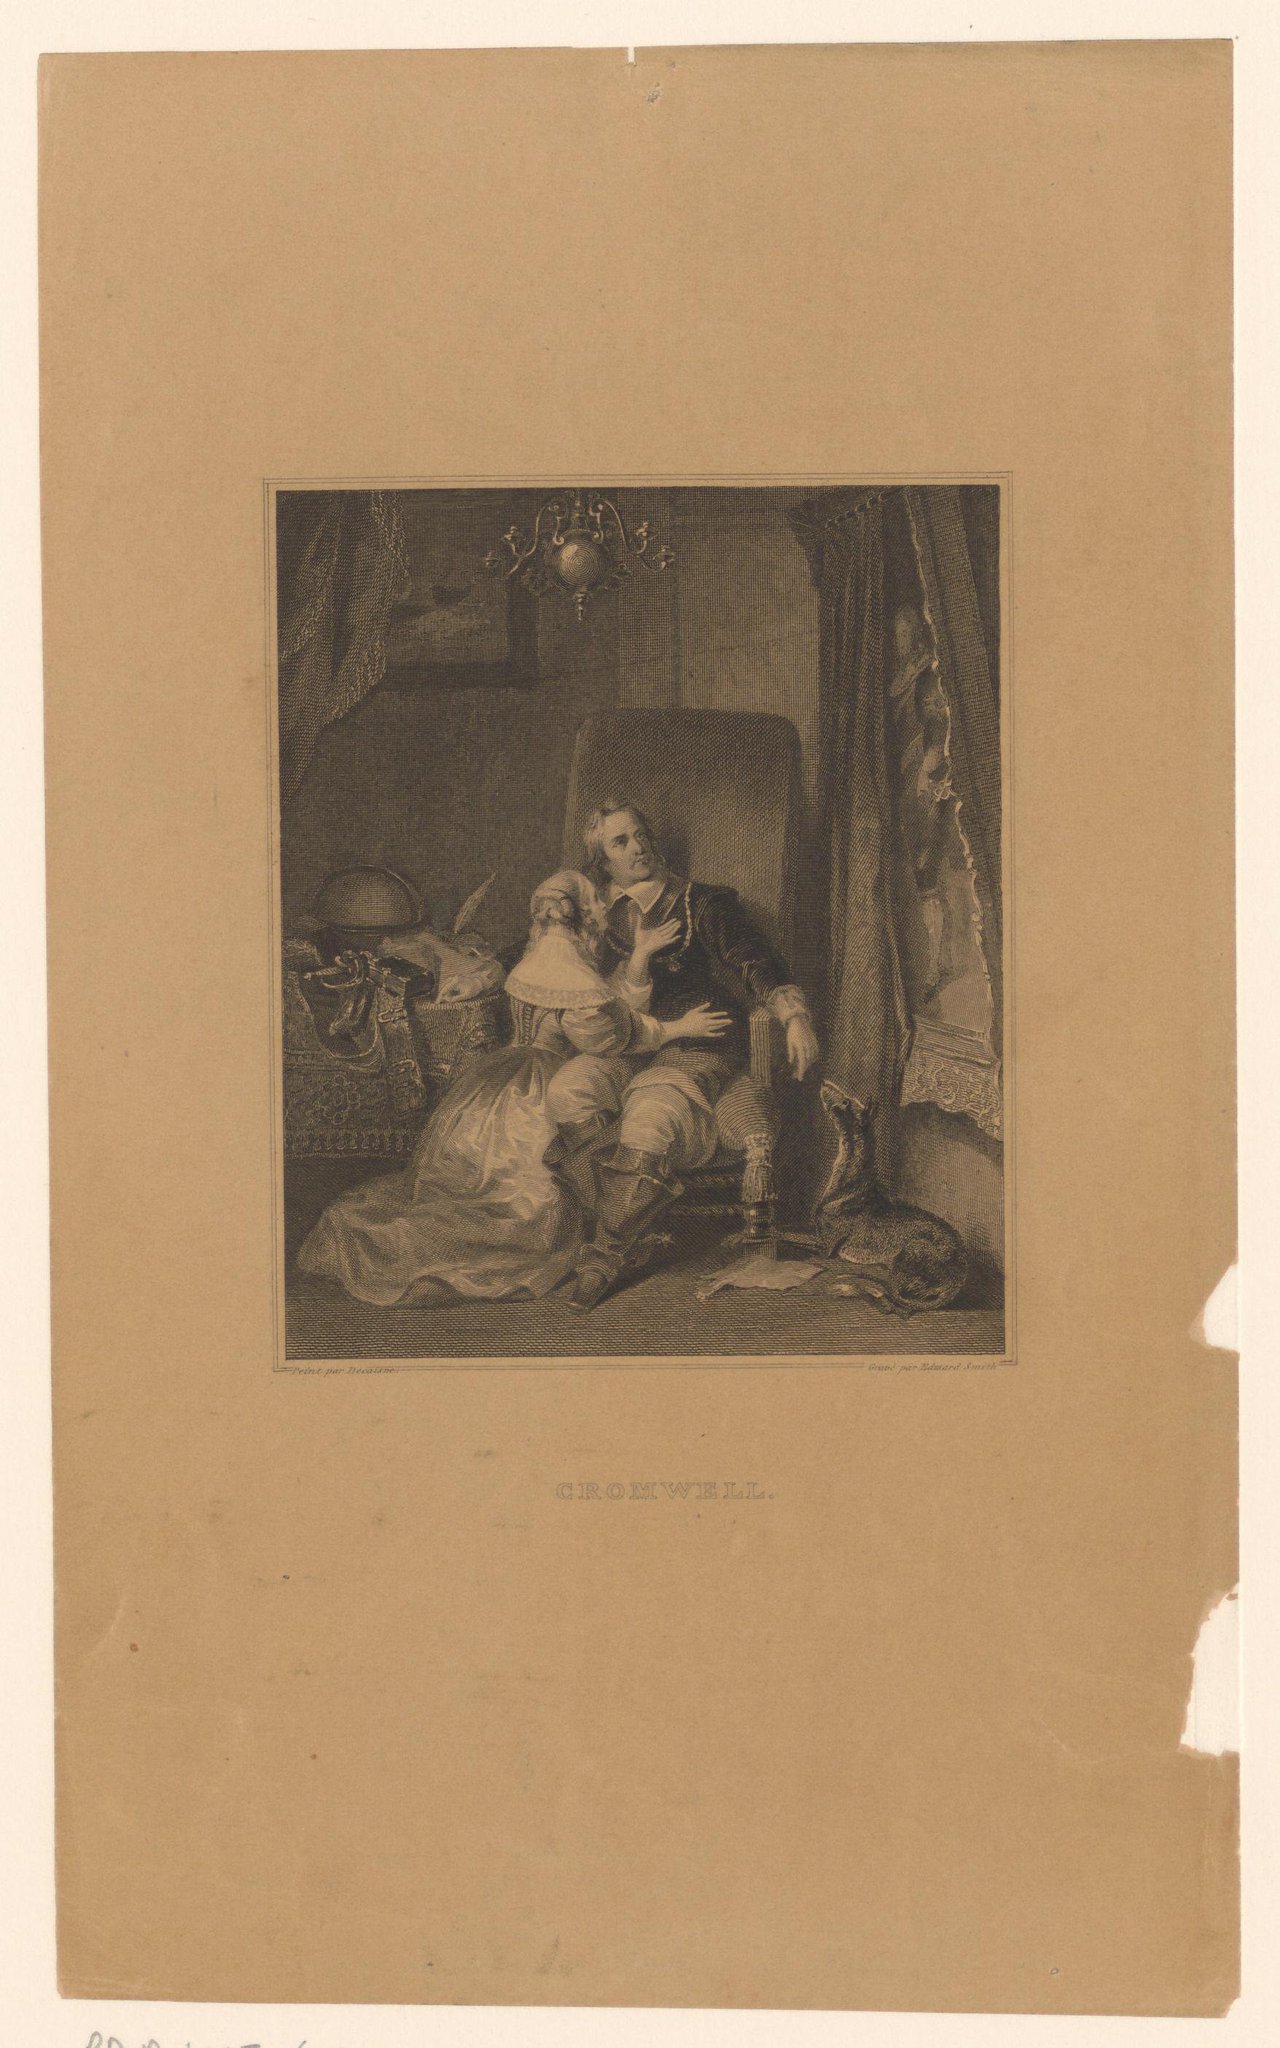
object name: print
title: Vrouw zit geknield bij een man in een stoel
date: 1829-1830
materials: paper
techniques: etching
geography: paris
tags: london, oliver cromwell, historical persons, kneeling on both knees - aa - female human figure, dog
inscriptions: collector's mark: Lugt 2228